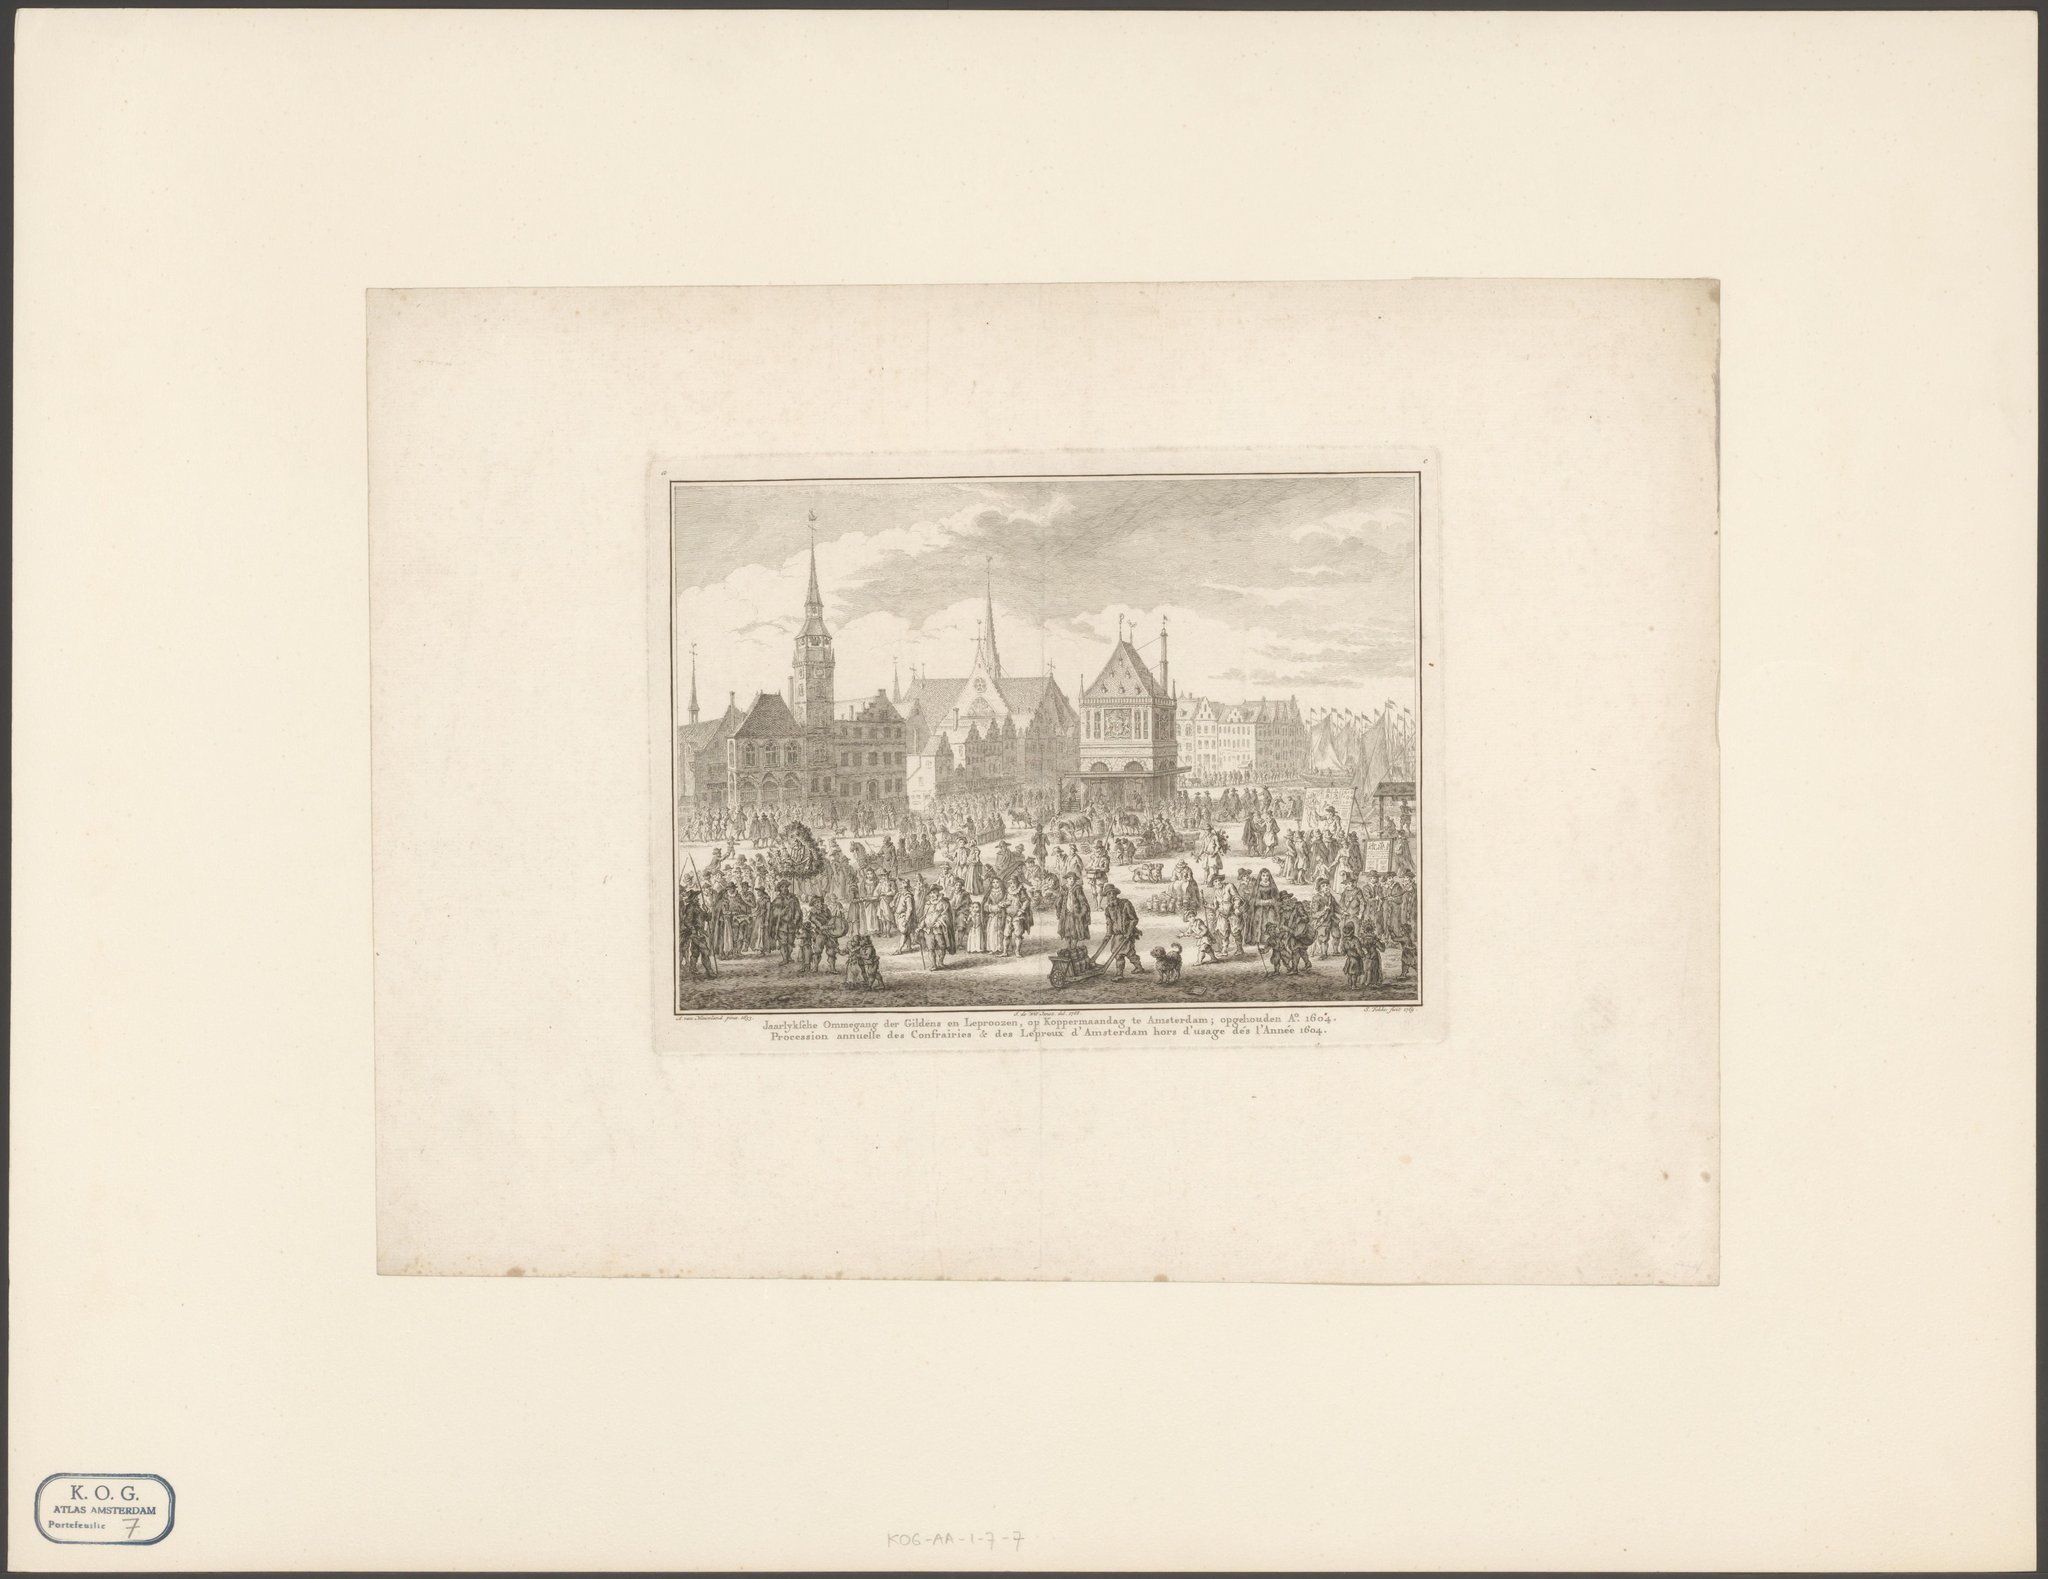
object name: print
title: Jaarlyksche Ommegang der Gildens en Leproozen, op Koppermaandag te Amsterdam; opgehouden Ao. 1604 / Procession annuelle des Confrairies & des Lépreux d'Amsterdam hors d'usage dés l'Année 1604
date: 1769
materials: paper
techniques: etching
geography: amsterdam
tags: square, place, circus, etc., city-view in general; 'veduta', townhall, weigh-house, leper's procession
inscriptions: collector's mark: ‘7’ Lugt 1641b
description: Onderwerpsrubriek binnen de Atlas Amsterdam: Dam (voor 1835).